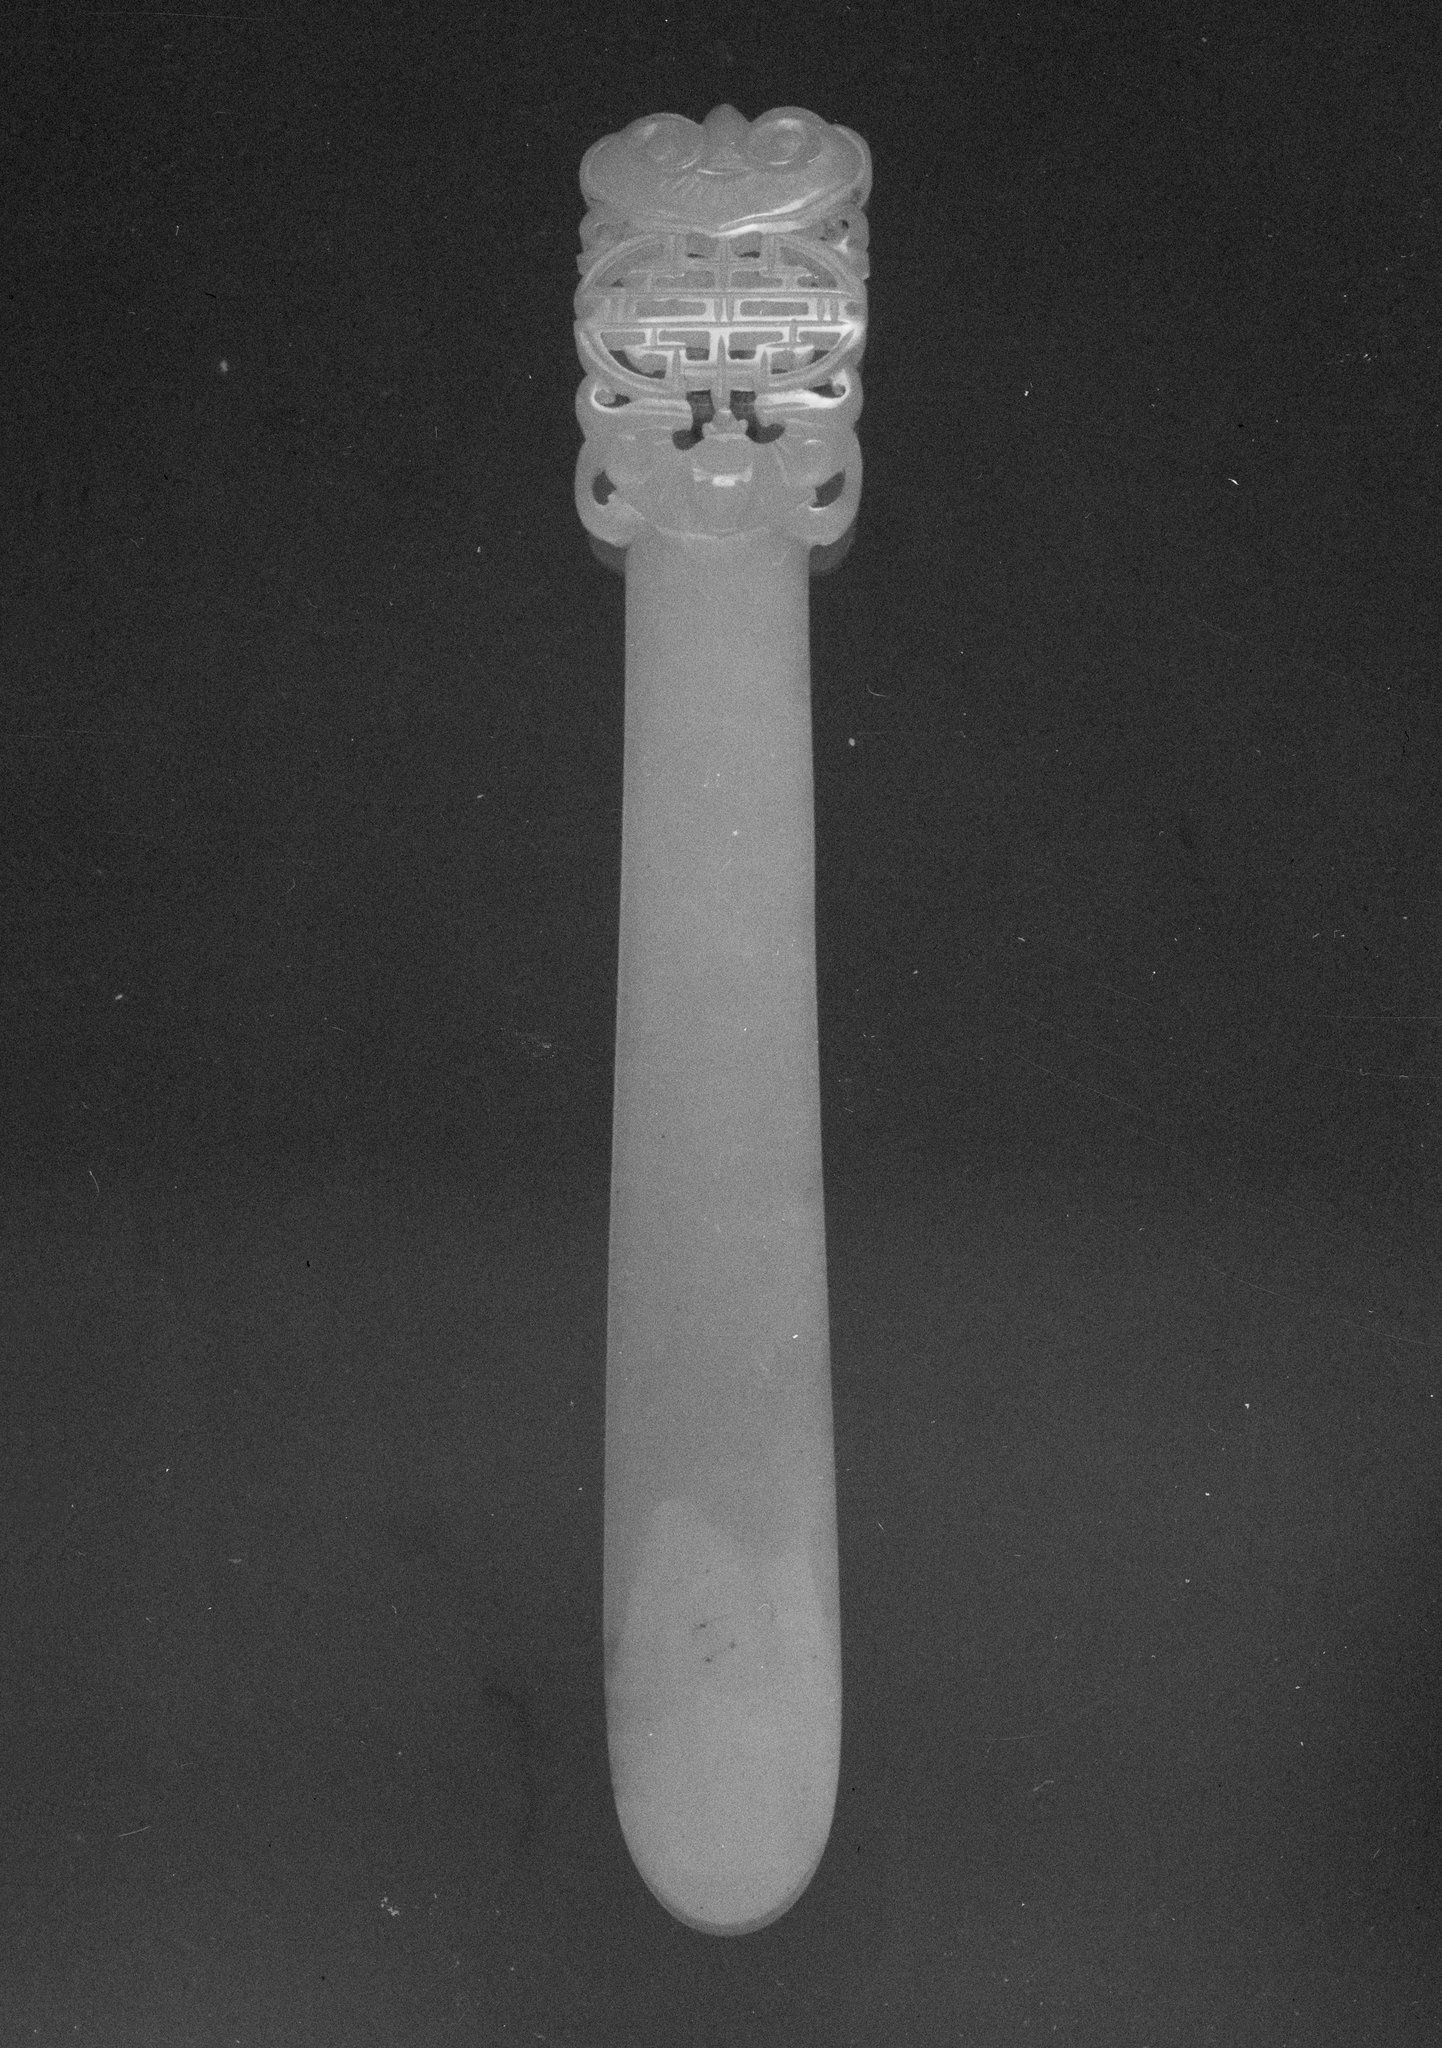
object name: hairpin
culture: chinese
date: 1801-1900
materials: jade